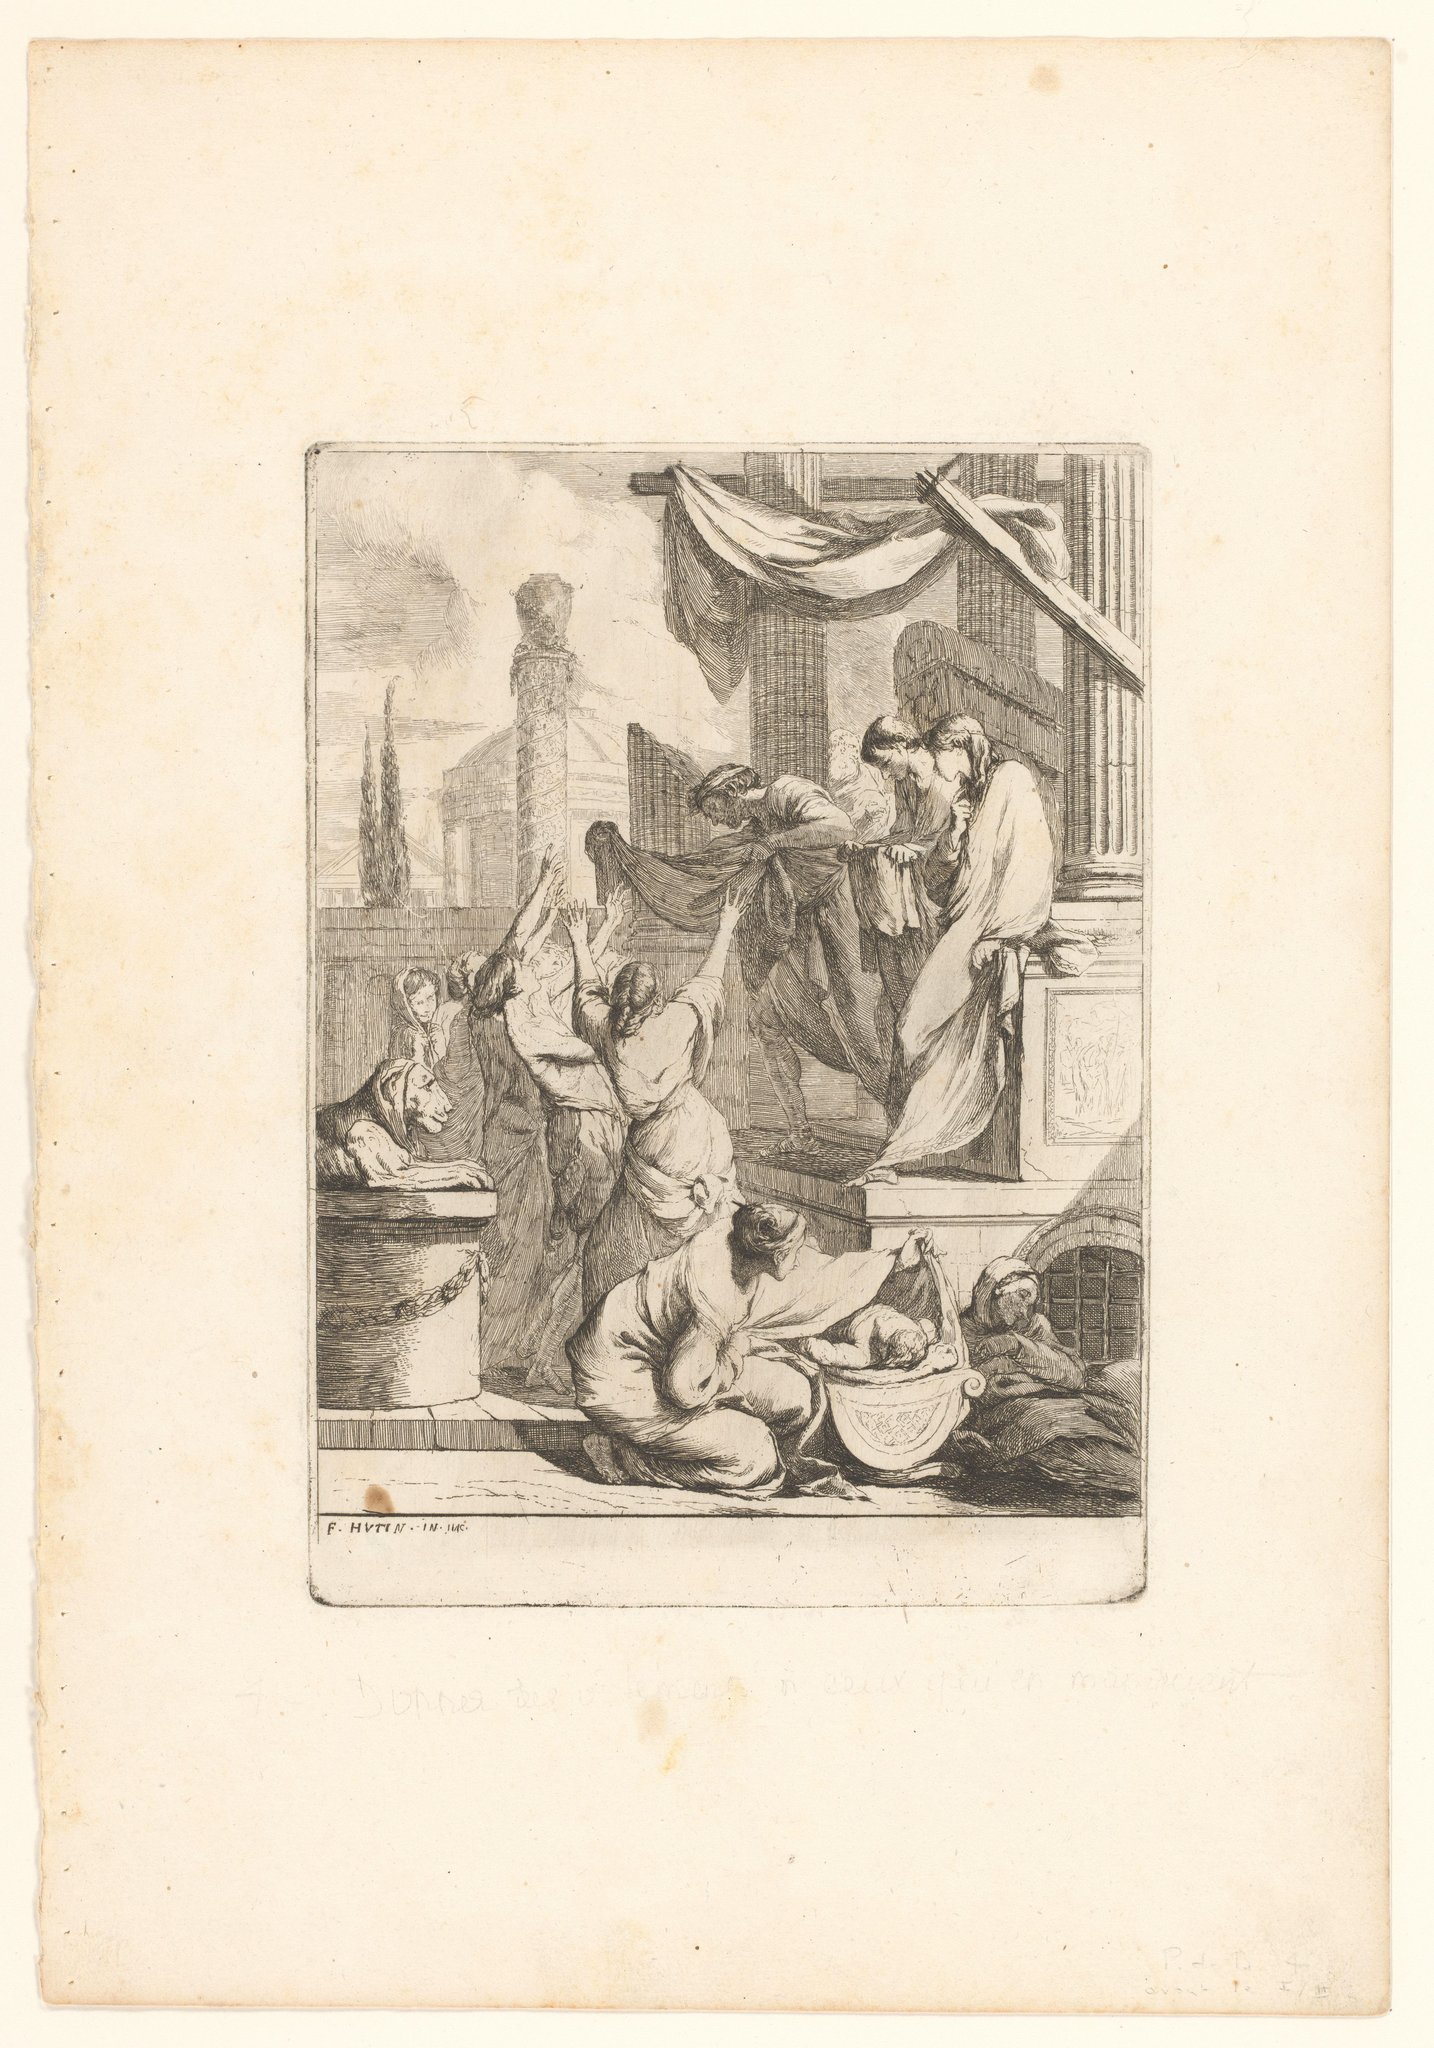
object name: print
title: De zeven werken van barmhartigheid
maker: françois hutin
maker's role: painter, print maker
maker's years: 1685-1758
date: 1730-1750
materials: paper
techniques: etching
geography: dresden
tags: clothing the naked, 'nudus vestitur' ~ one of the (seven) acts of mercy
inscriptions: collector's mark, collector's mark: Lugt 2760, collector's mark: Lugt 2228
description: Onderdeel van een serie van zeven werken van barmhartigheid met voorstellingen in antieke setting.